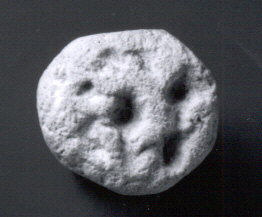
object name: stamp seal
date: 500-401 BCE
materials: ceramic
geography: levant